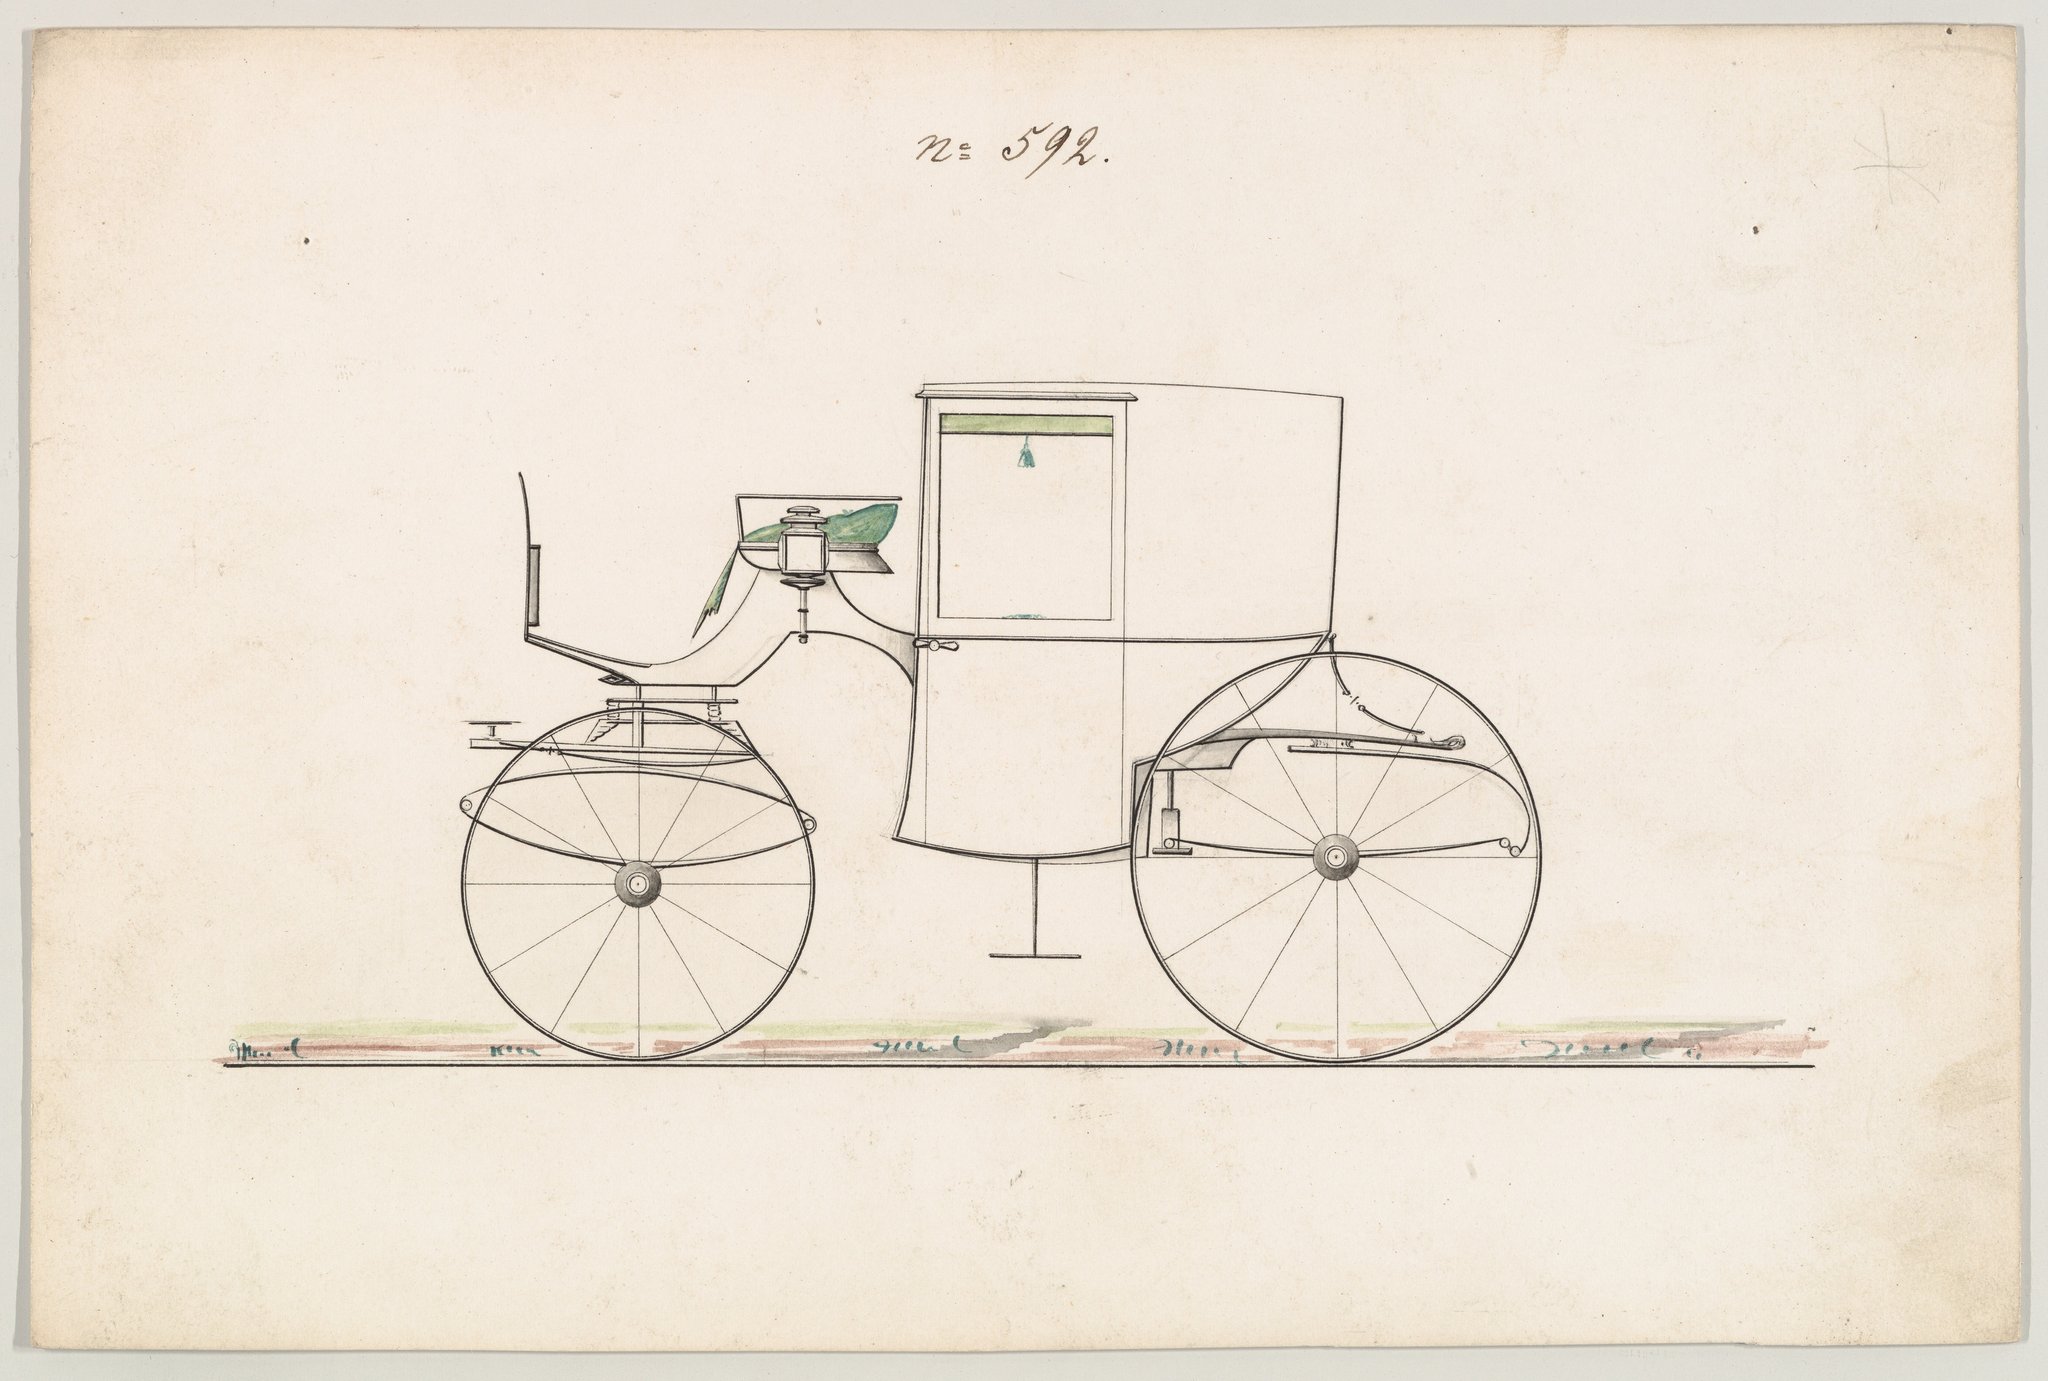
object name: drawing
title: Coupe #592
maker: brewster & co.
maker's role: manufacturer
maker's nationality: american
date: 1850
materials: gouache, ink, watercolor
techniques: pen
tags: carriages